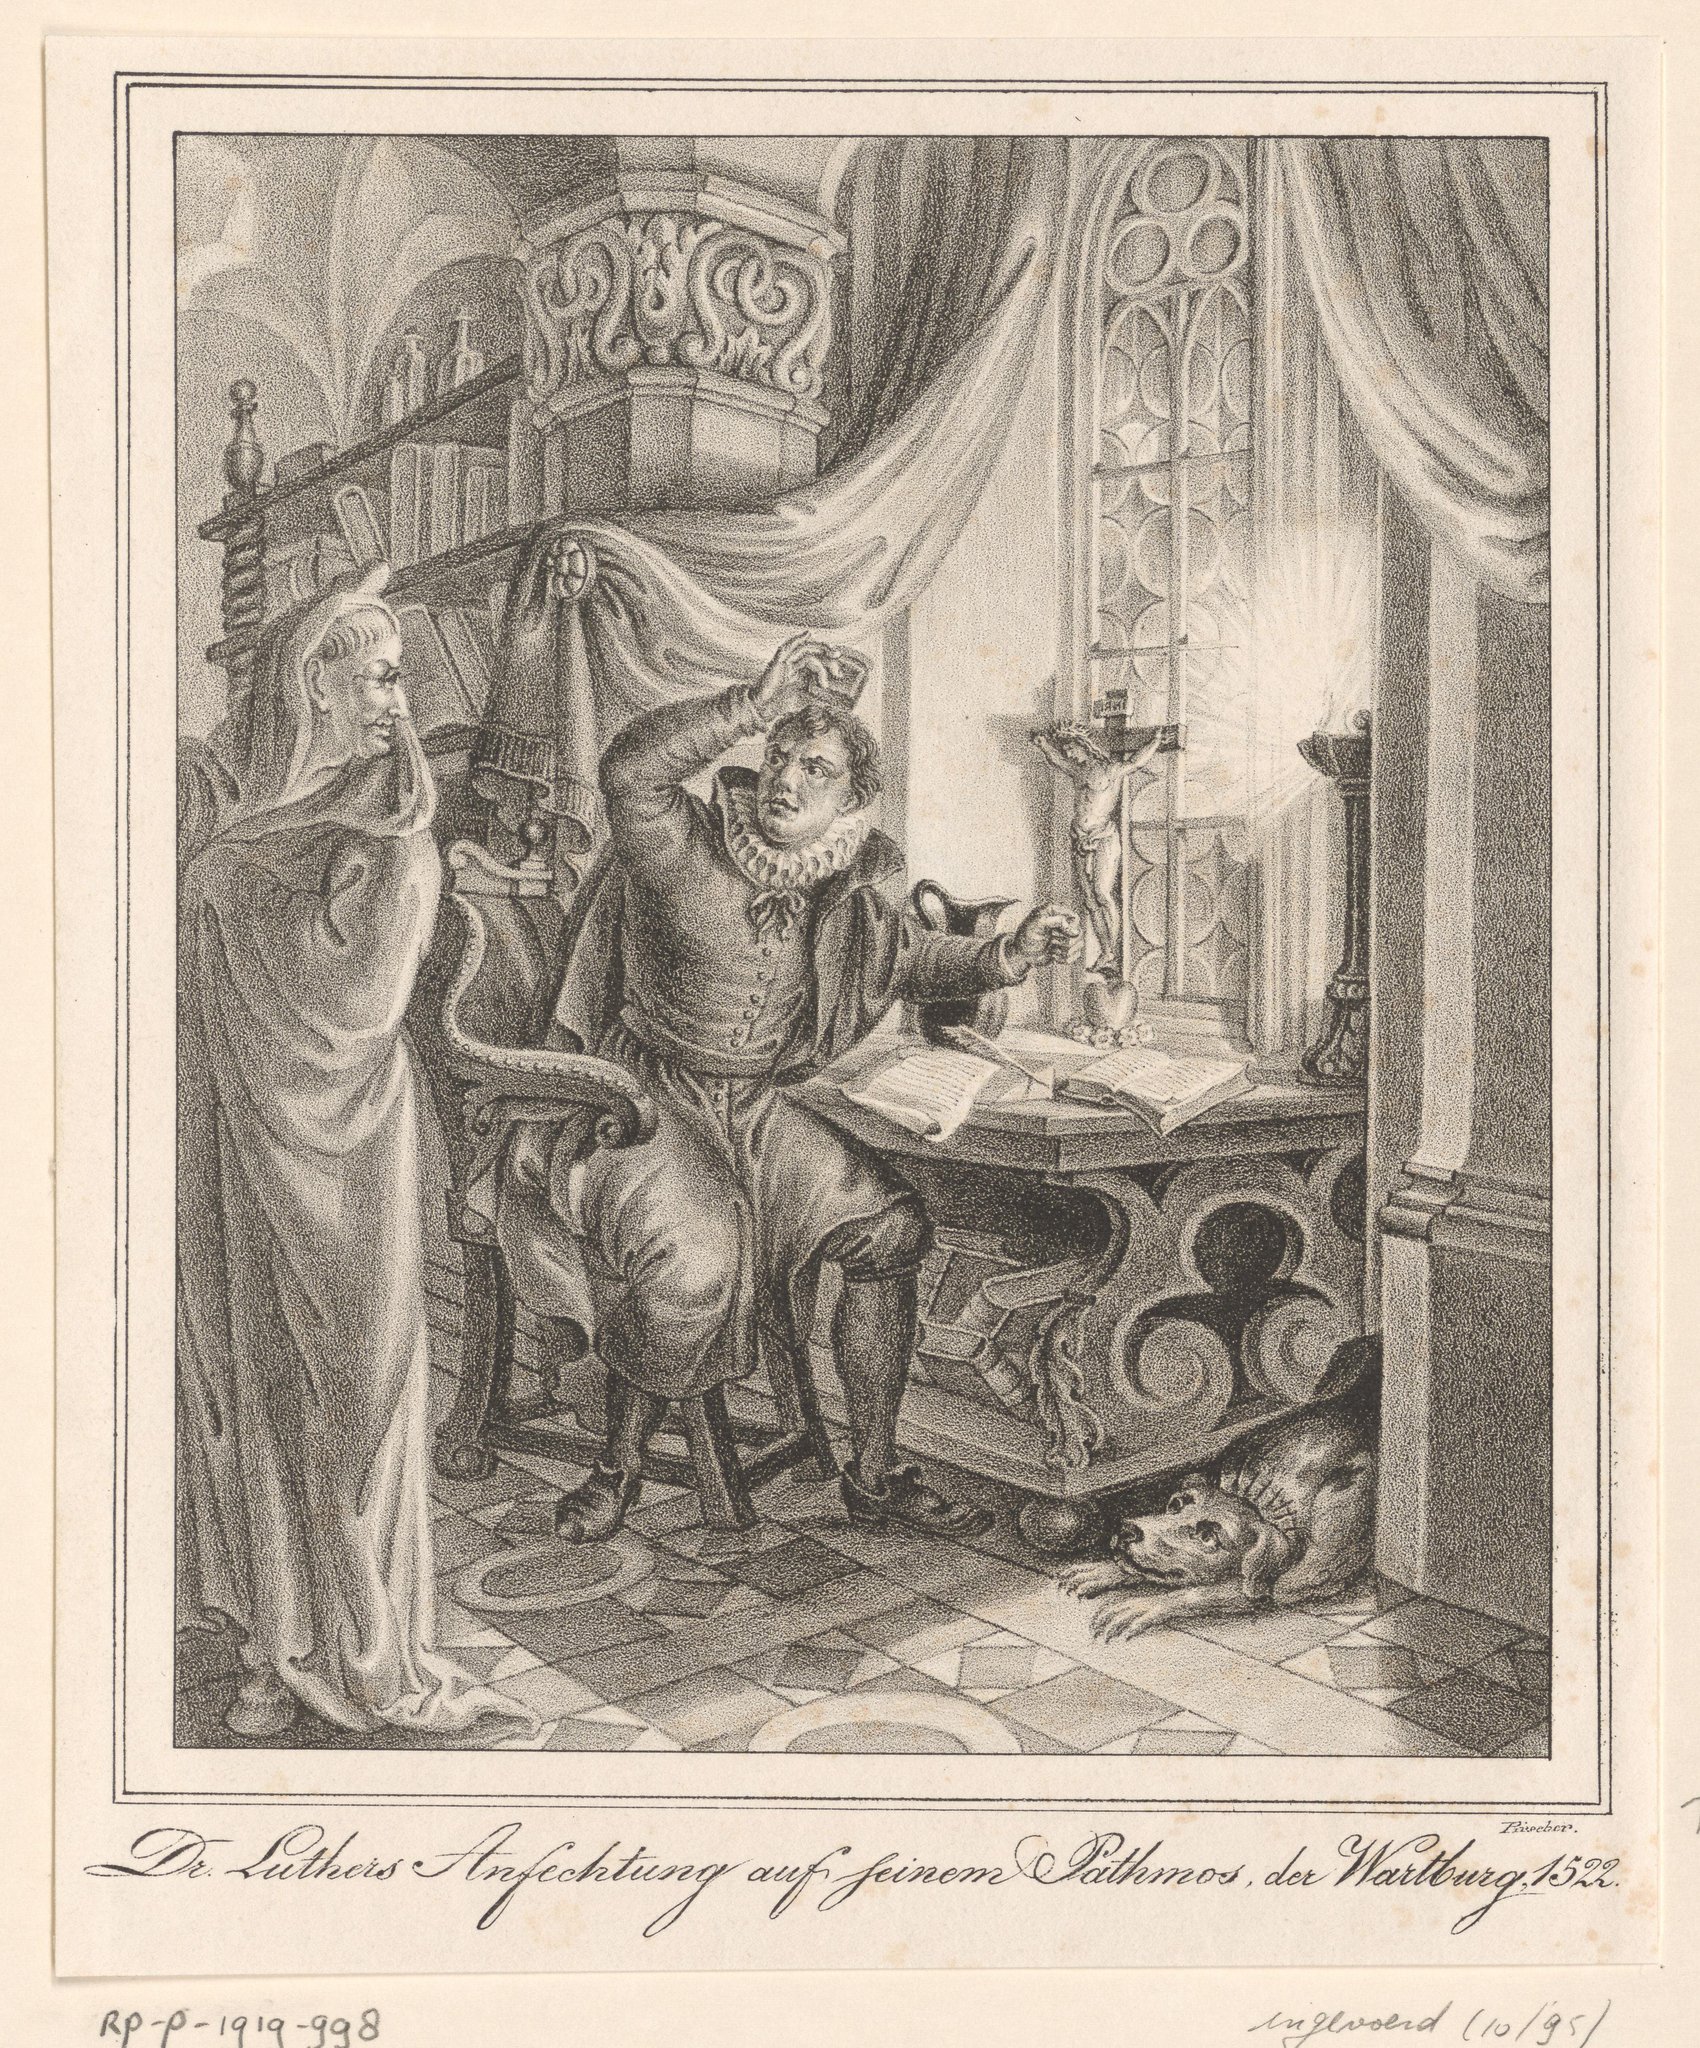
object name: print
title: Dr. Luthers Anfechtung auf seinem Pathmos, der Wartburg, 1522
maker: karl dietrich pirscher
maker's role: print maker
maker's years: 1791-1857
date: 1820-1857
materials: paper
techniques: lithograph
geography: germany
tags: priest, martin luther, writing-table, writing-desk, historical persons, crucifix ~ personal devotion, human-shaped devil, banishment, exile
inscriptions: collector's mark: Lugt 2228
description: De figuur links is een satan-figuur met bokkenpoot die onder de mantel uit komt. Luther noemde kasteel Wartburg zijn Patmos, naar de plek waar Johannes de Evangelist werd verbannen.